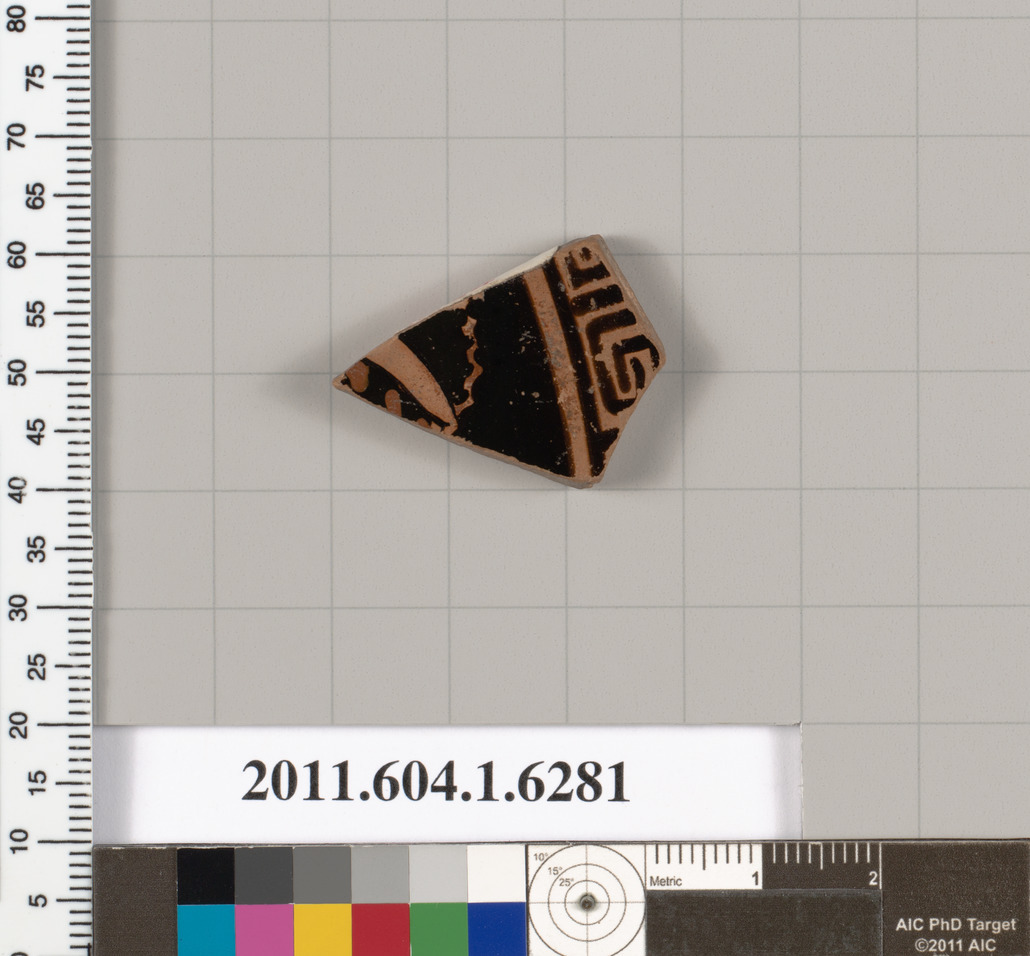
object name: kylix fragment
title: Terracotta fragment of a kylix (drinking cup)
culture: greek, attic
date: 500-480 BCE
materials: terracotta